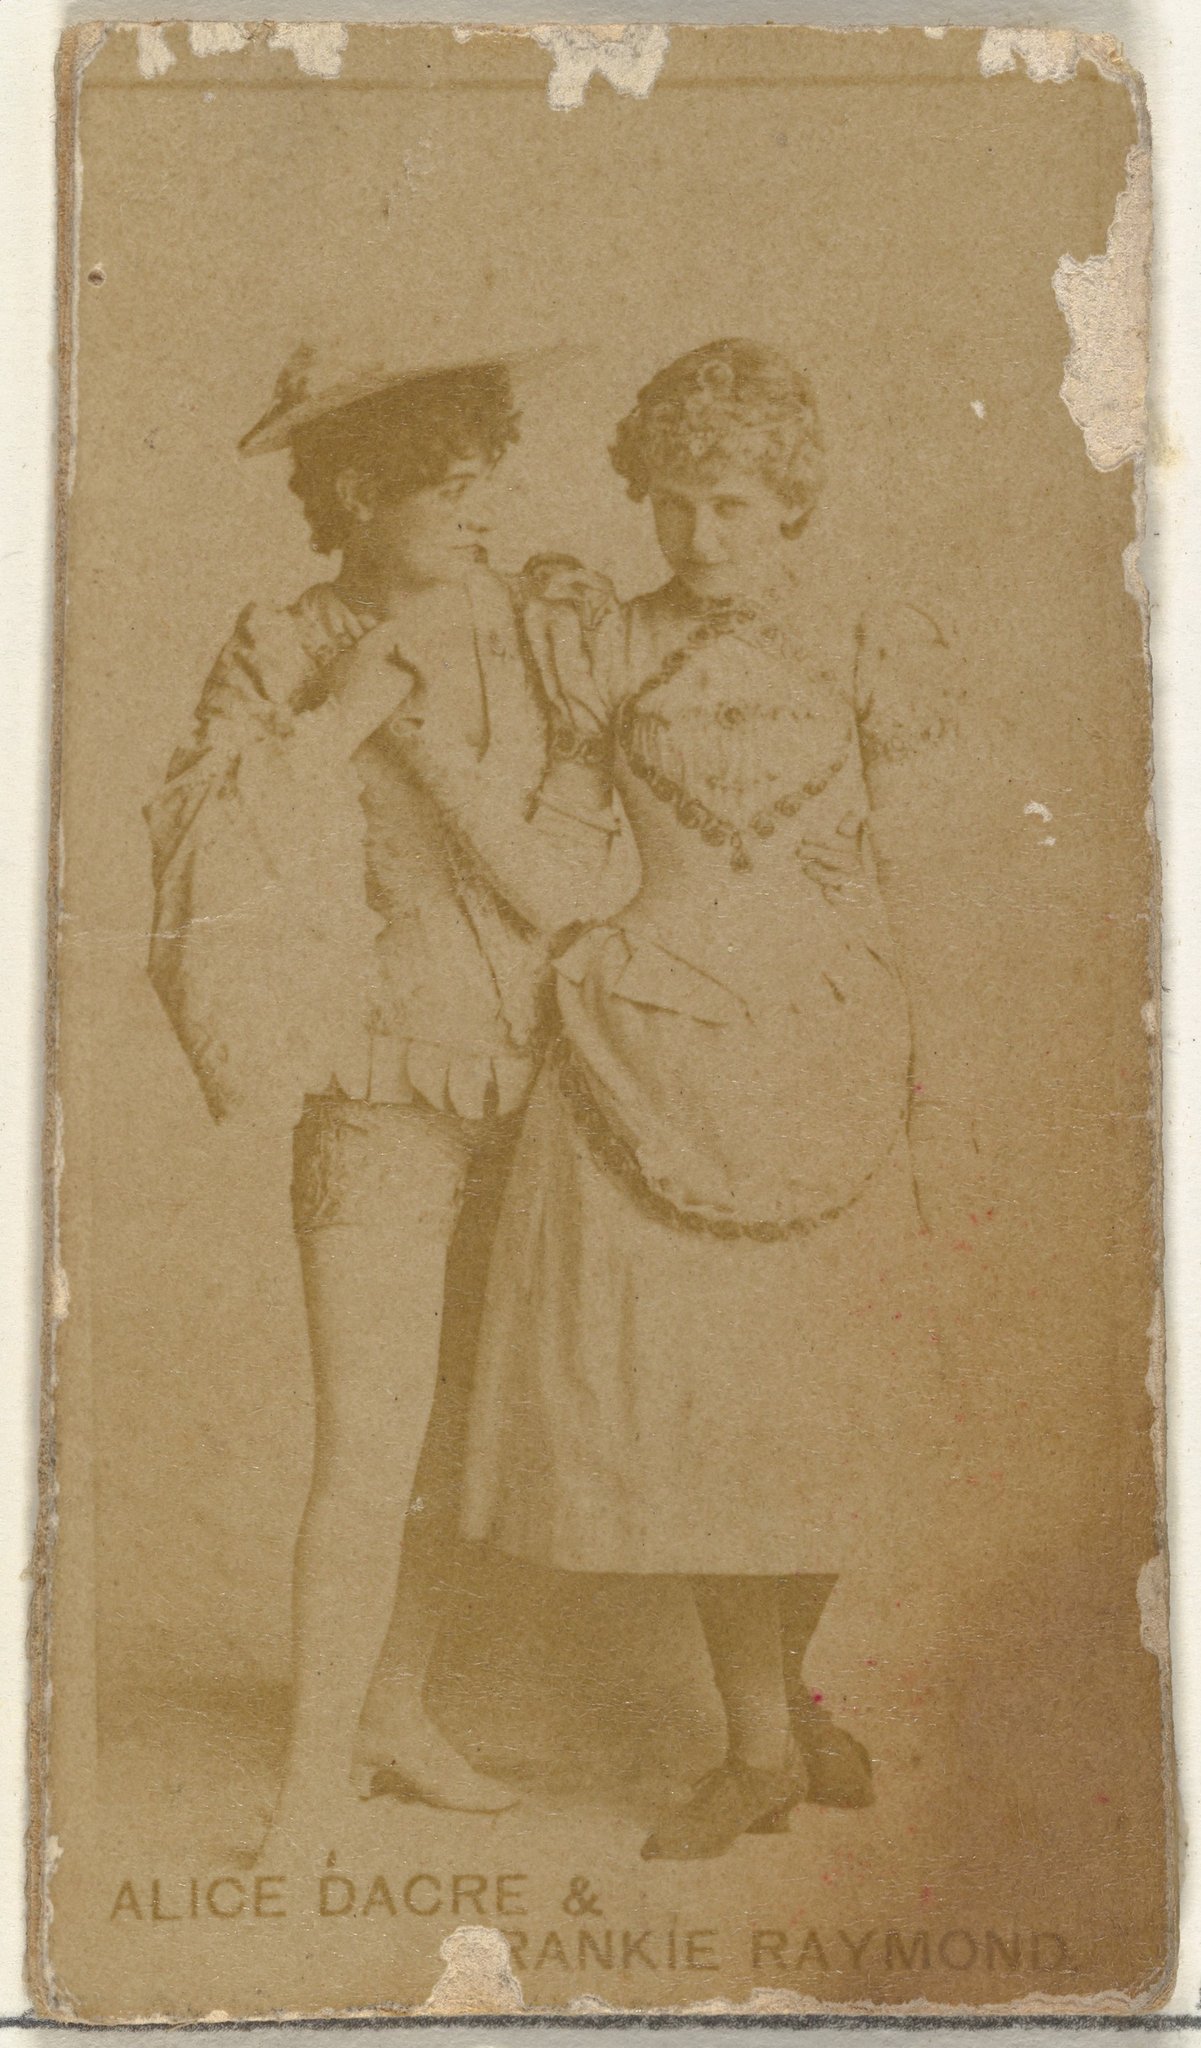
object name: photograph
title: Alice Dacre and Frankie Raymond, from the Actors and Actresses series (N145-8) issued by Duke Sons & Co. to promote Duke Cigarettes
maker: w. duke, sons & co.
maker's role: publisher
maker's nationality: american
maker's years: 1870-1920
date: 1891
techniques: albumen silver print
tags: portraits,women,actresses